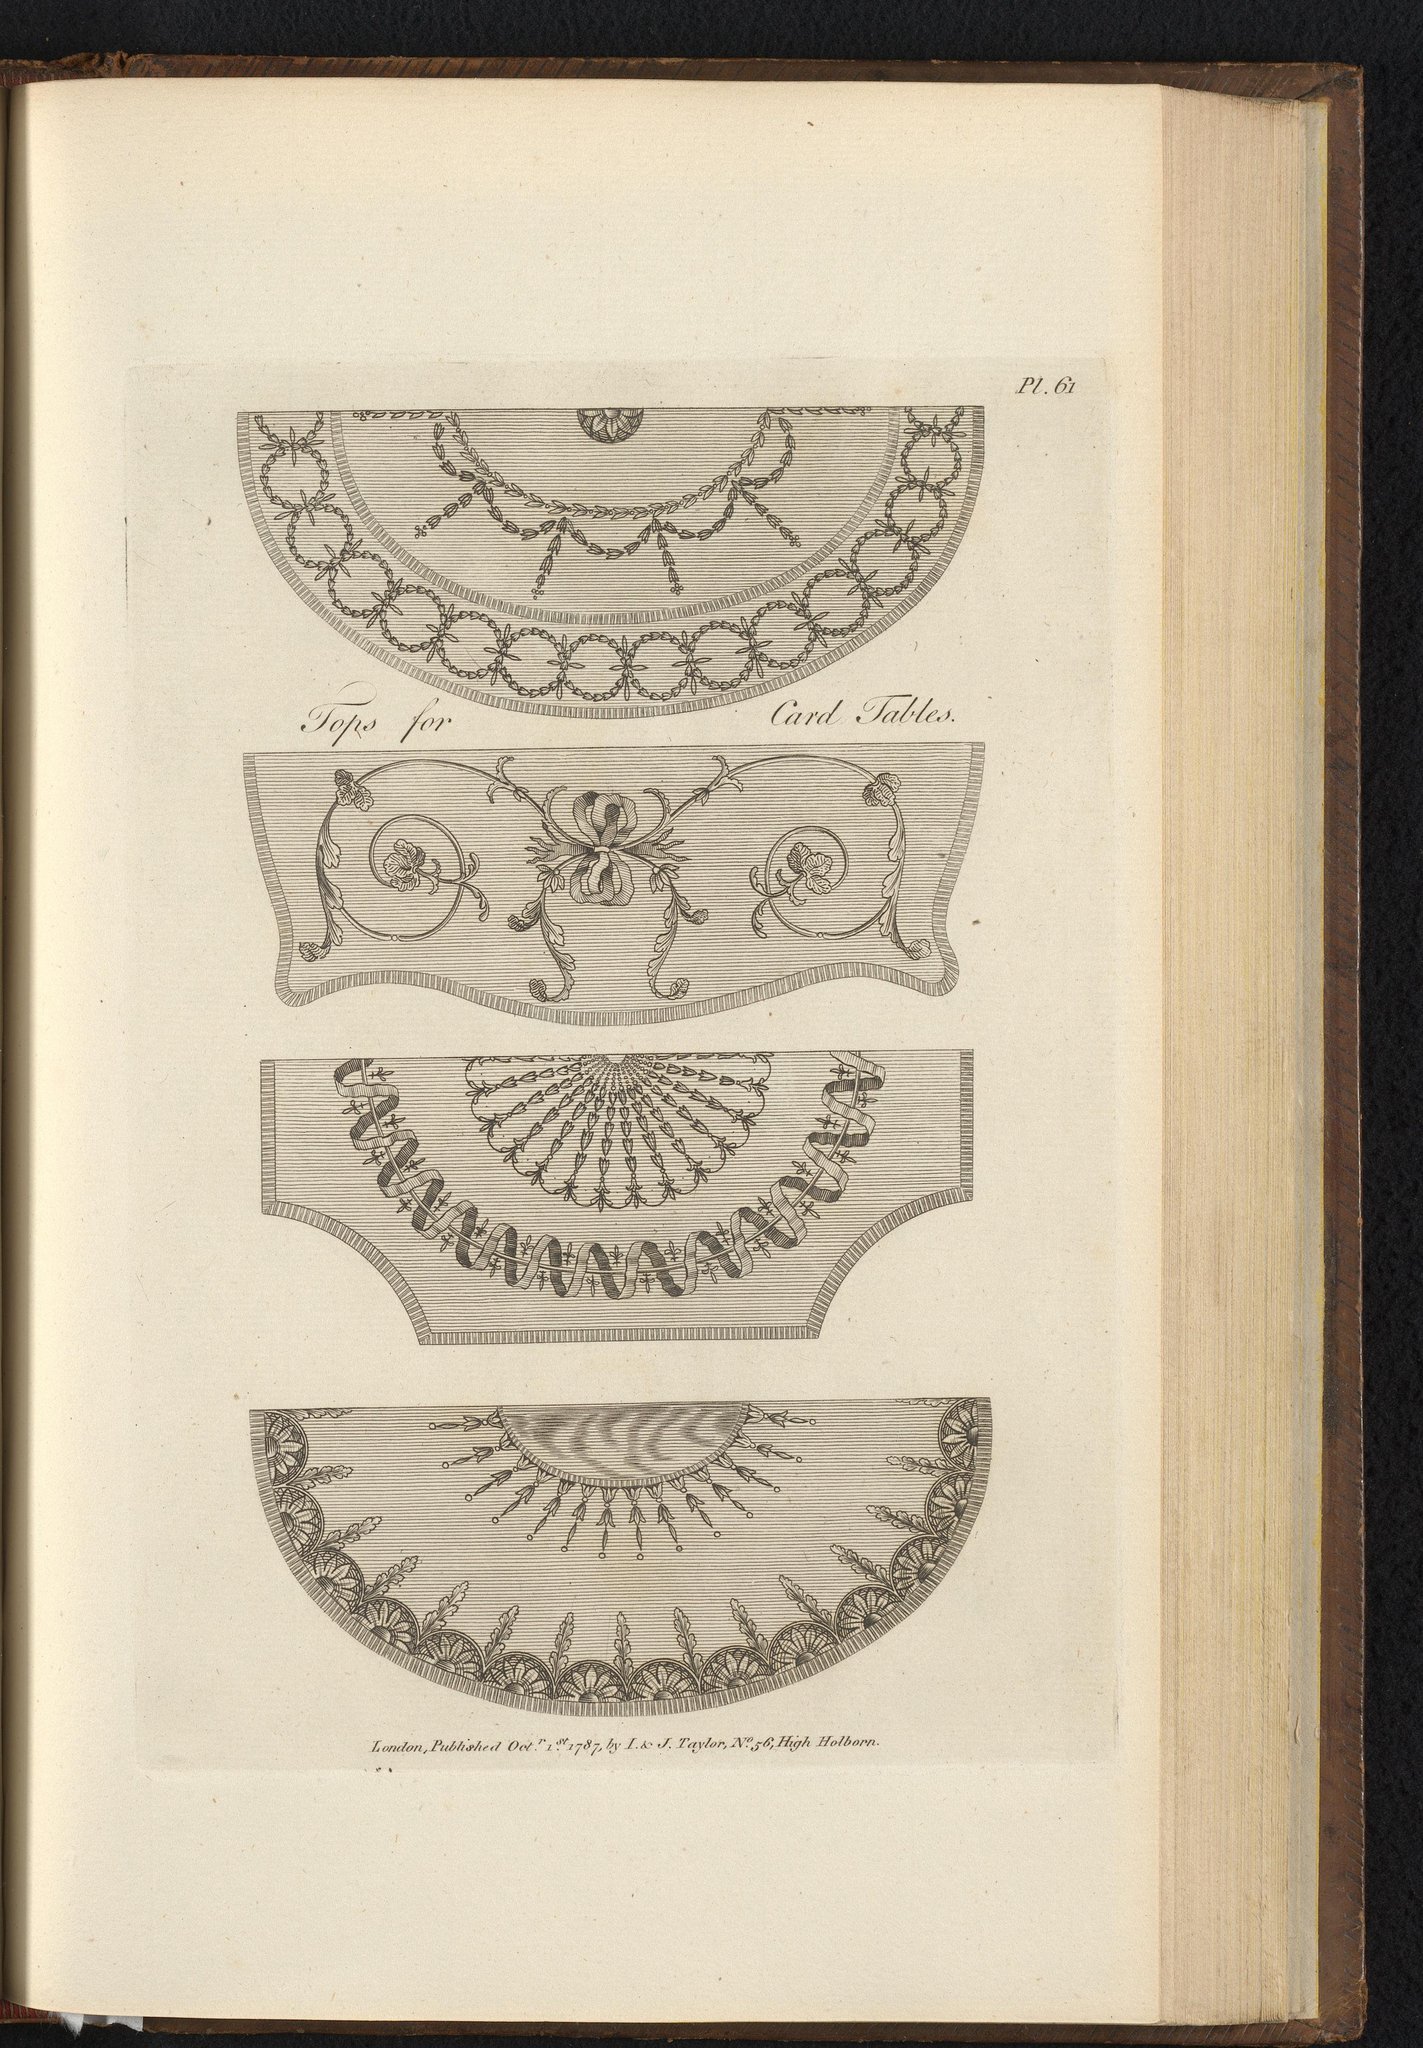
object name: print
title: Tops for Card Tables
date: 1787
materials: paper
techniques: engraving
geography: holborn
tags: table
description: Genummerd: Pl. 61. Prent maakt deel uit van een boek.